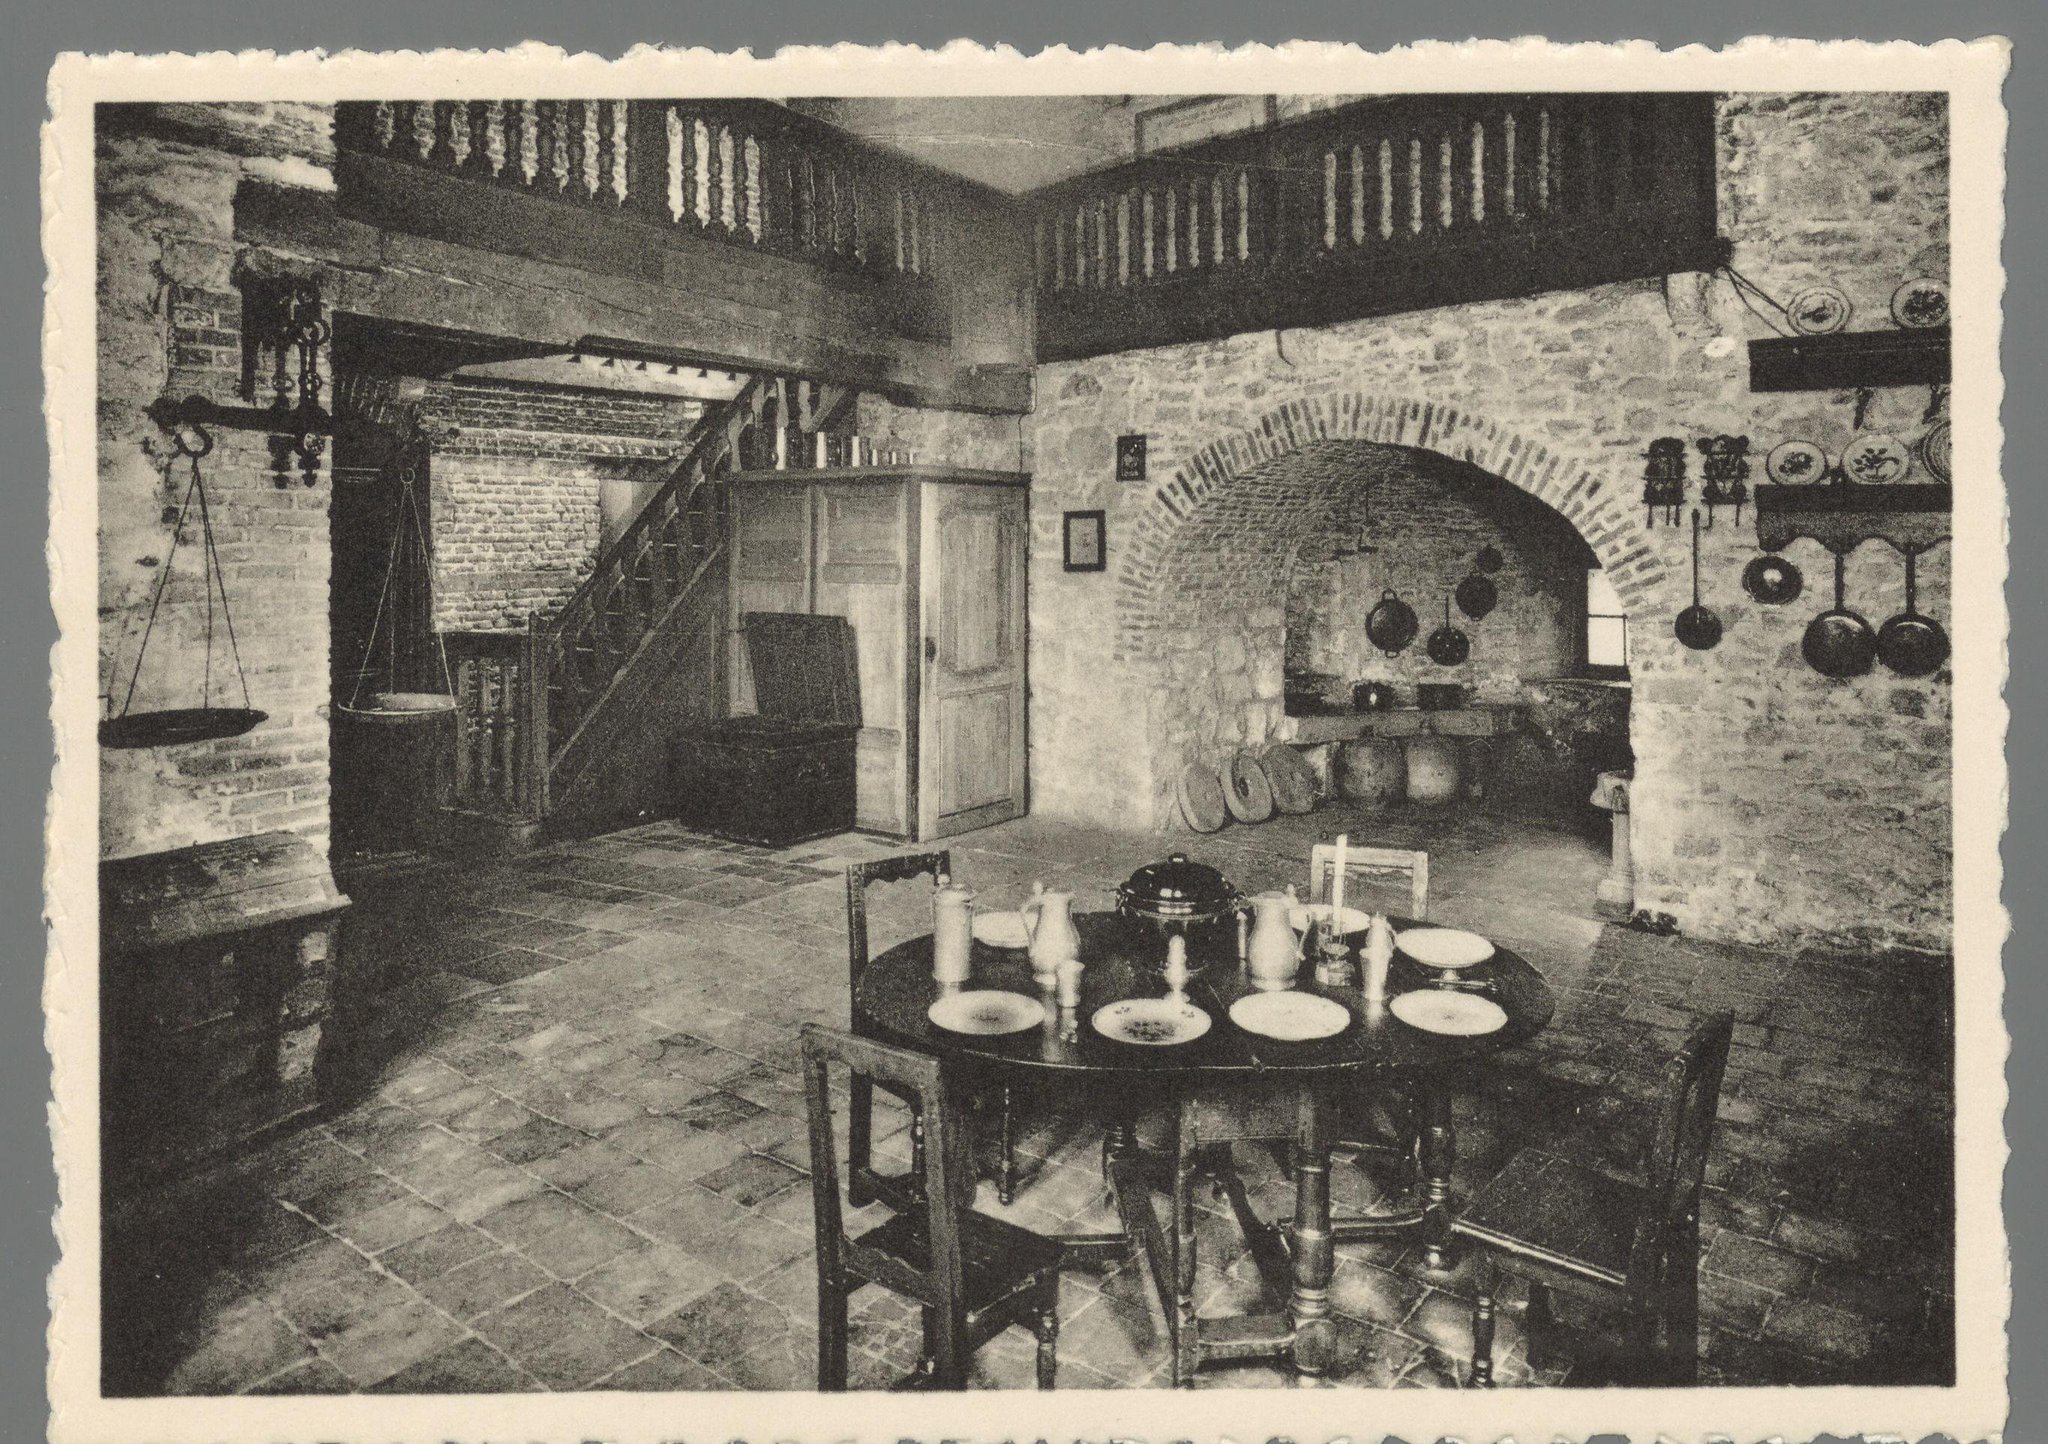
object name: photomechanical print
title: Vieille cuisine XIVe siècle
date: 1913-1950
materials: cardboard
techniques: photograph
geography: brussels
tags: castle, permanent exhibition, museum, interior ~ representation of a building